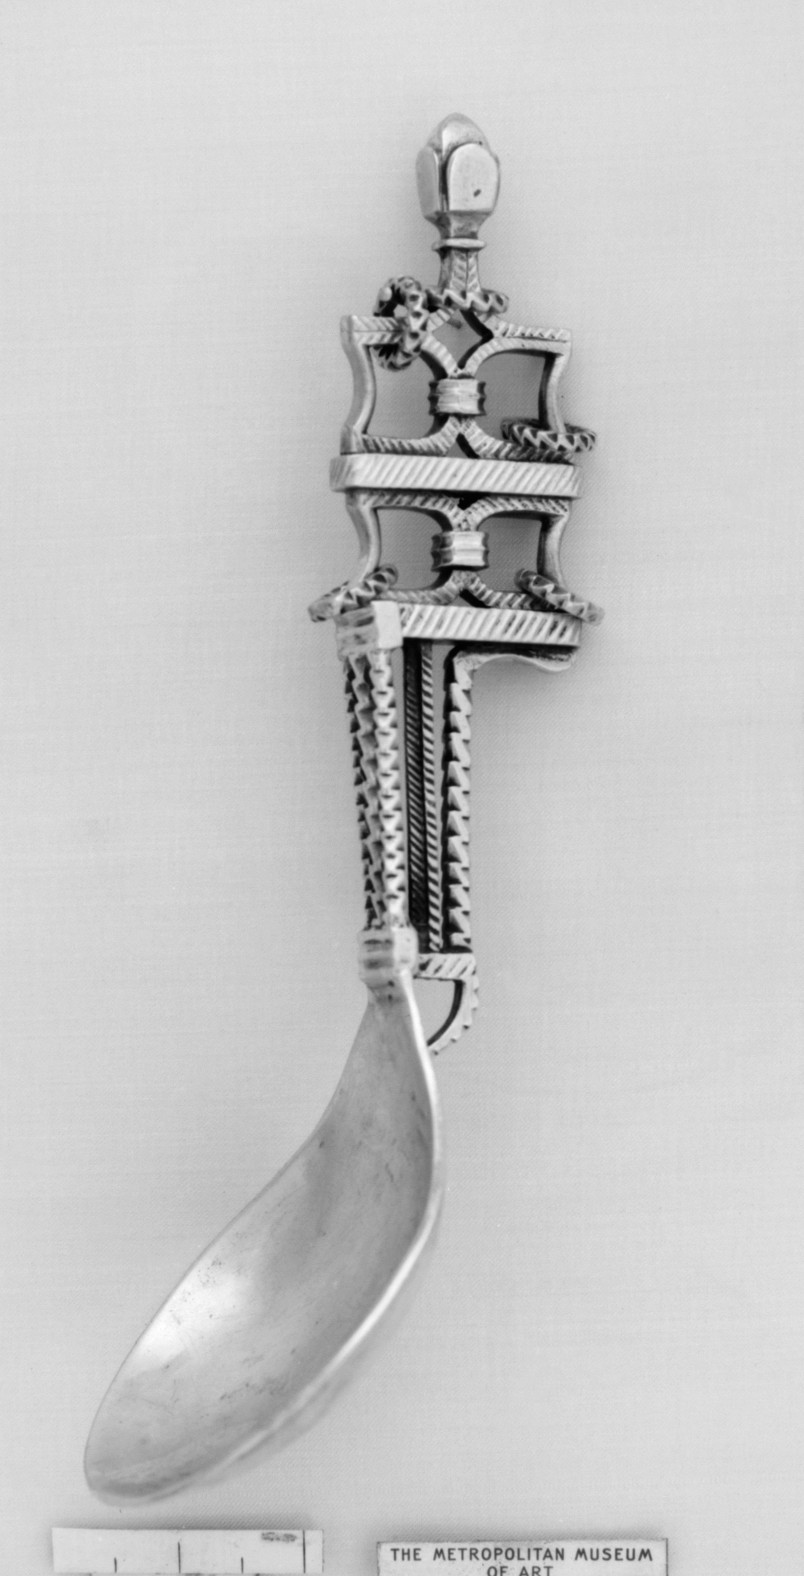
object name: rattle spoon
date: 1801-1900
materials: silver